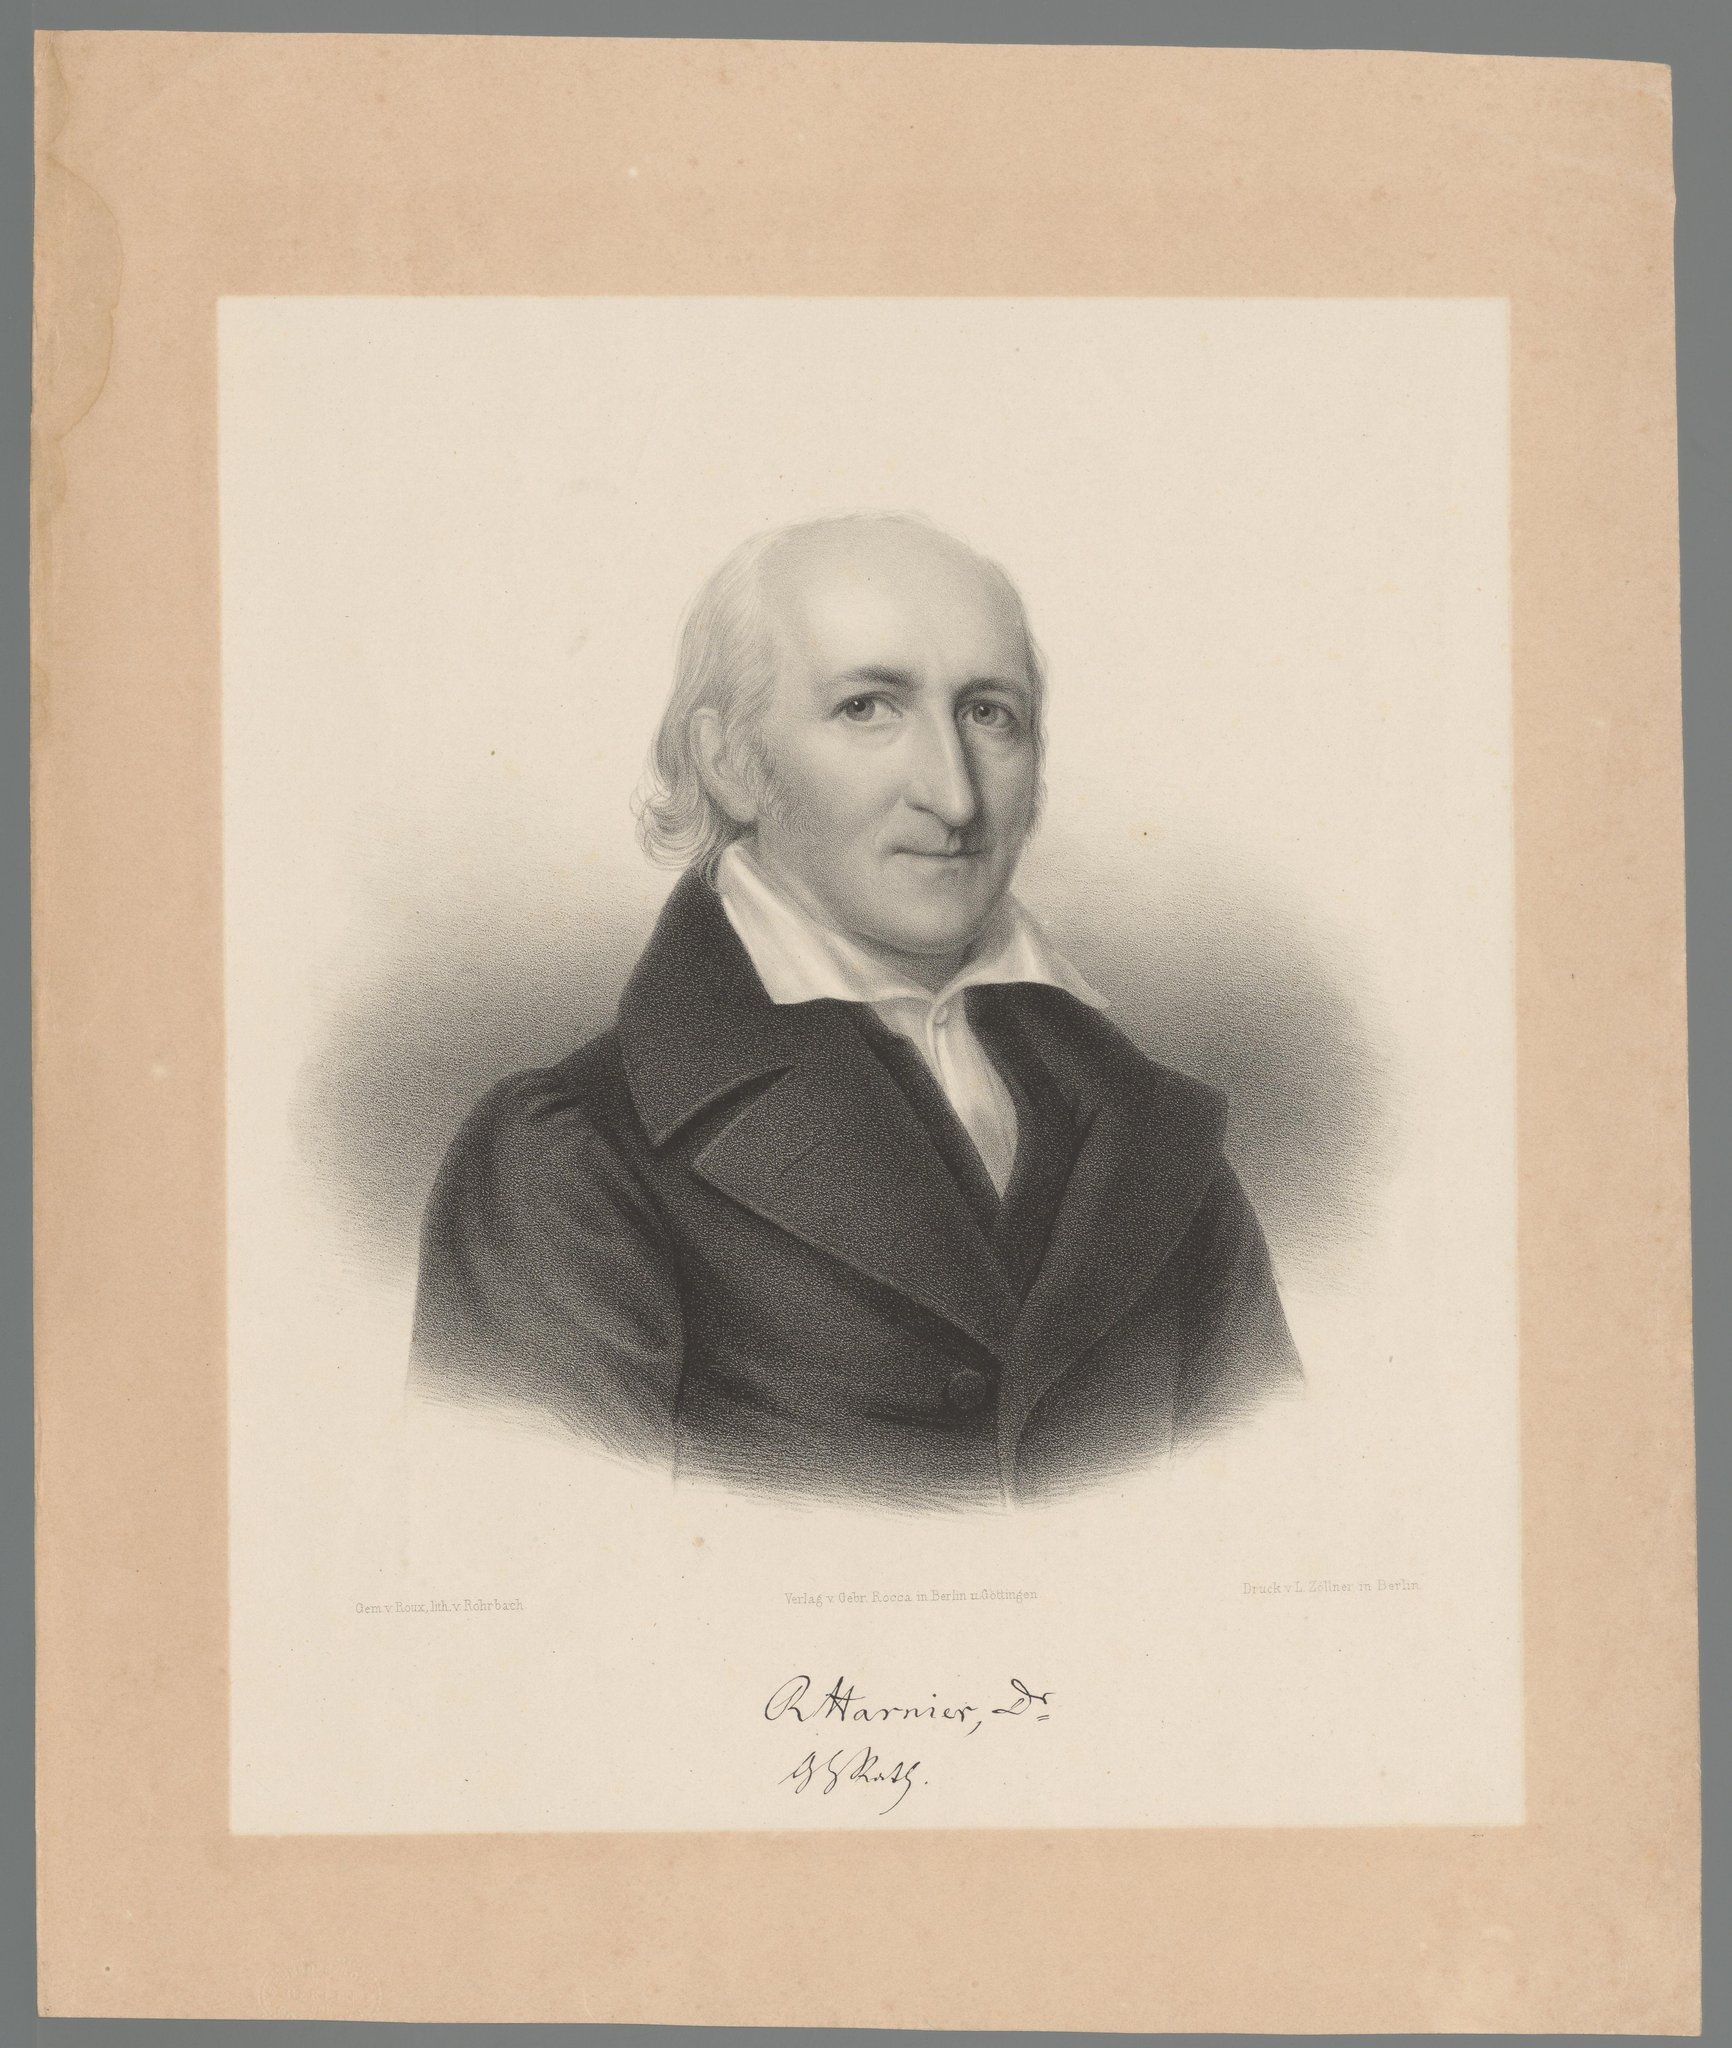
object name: print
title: Portret van R. Harnier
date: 1827-1862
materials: paper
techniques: lithograph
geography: berlin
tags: historical persons not known by name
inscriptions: collector's mark: Lugt 2228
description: Portret van een verder onbekende man, met handtekening in facsimile waarin de naam R. Harnier of Marnier te lezen is.